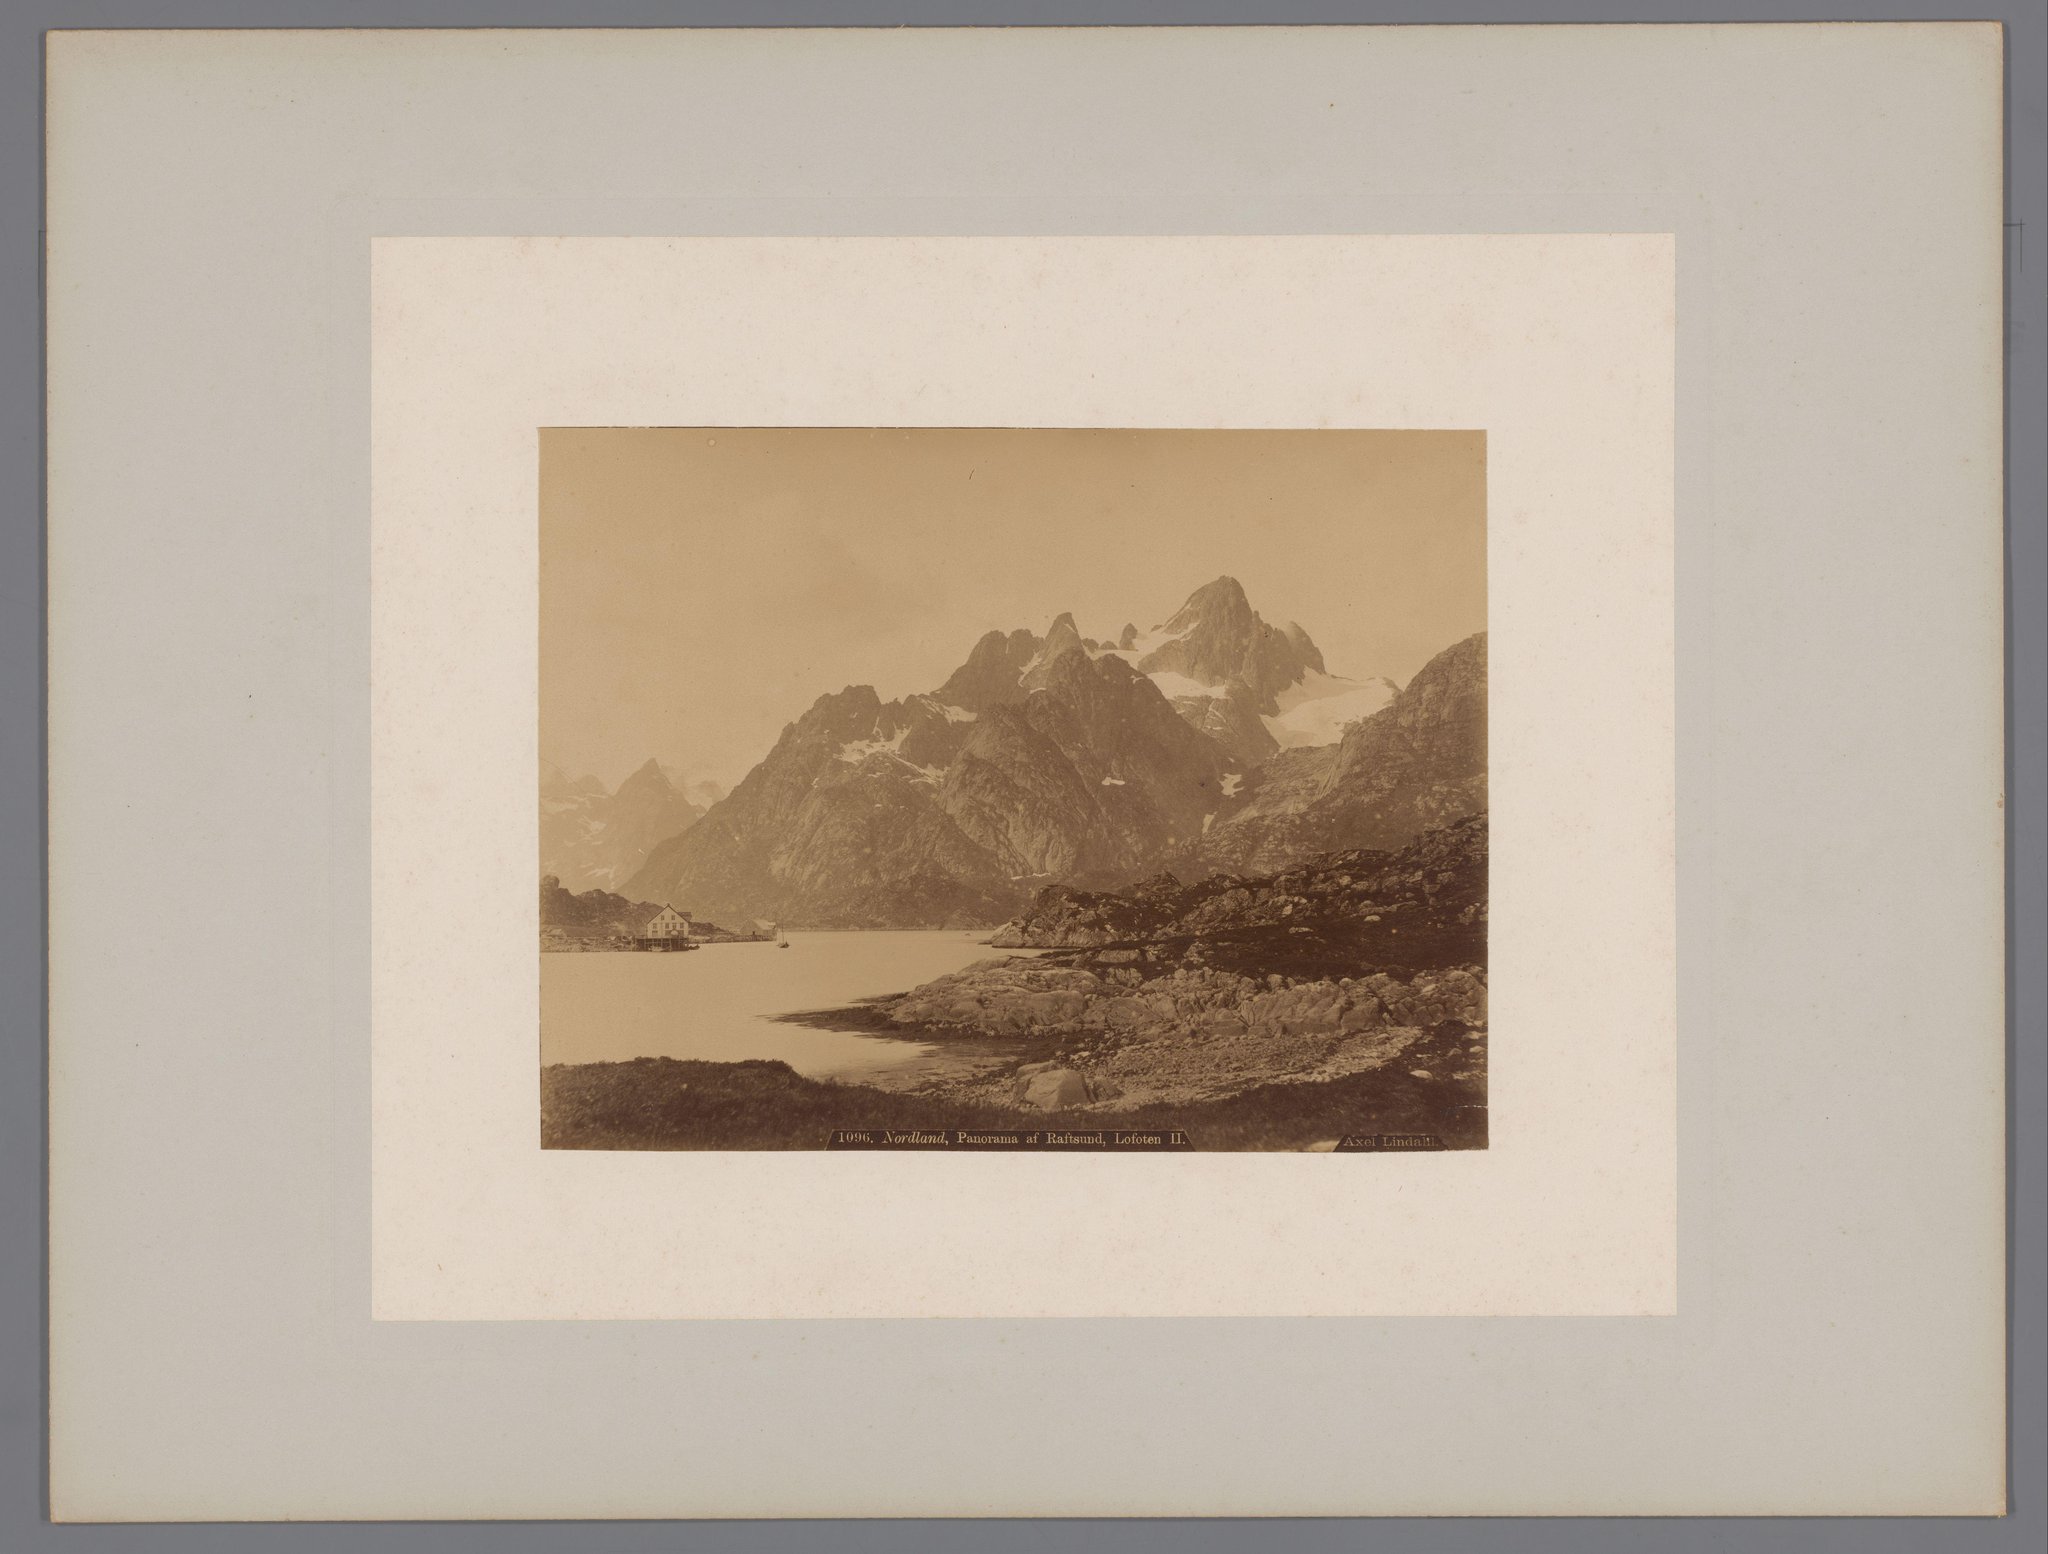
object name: photograph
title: Gezicht op de Raftsundet bij de Lofoten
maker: axel lindahl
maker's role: fotograaf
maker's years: 1841-1906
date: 1883-1900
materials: cardboard, paper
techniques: albumen print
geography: raftsundet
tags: fjord, sea loch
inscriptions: name: ‘1096.’